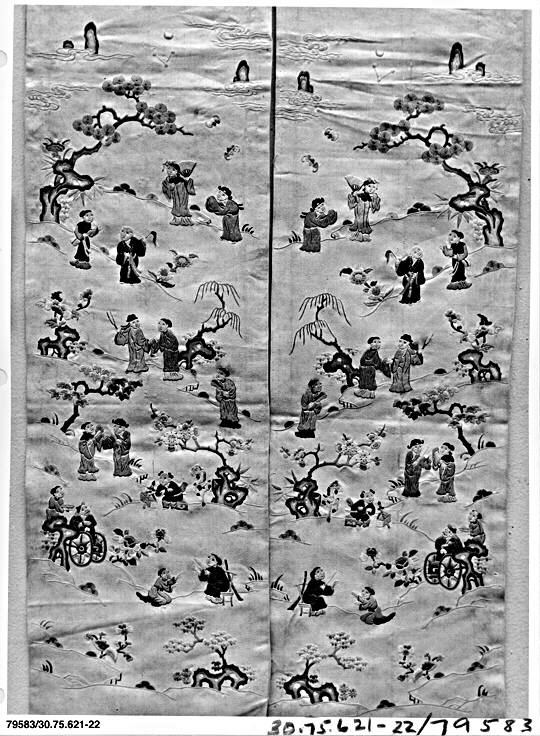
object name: sleeve band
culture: chinese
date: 1801-1900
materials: silk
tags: men,trees